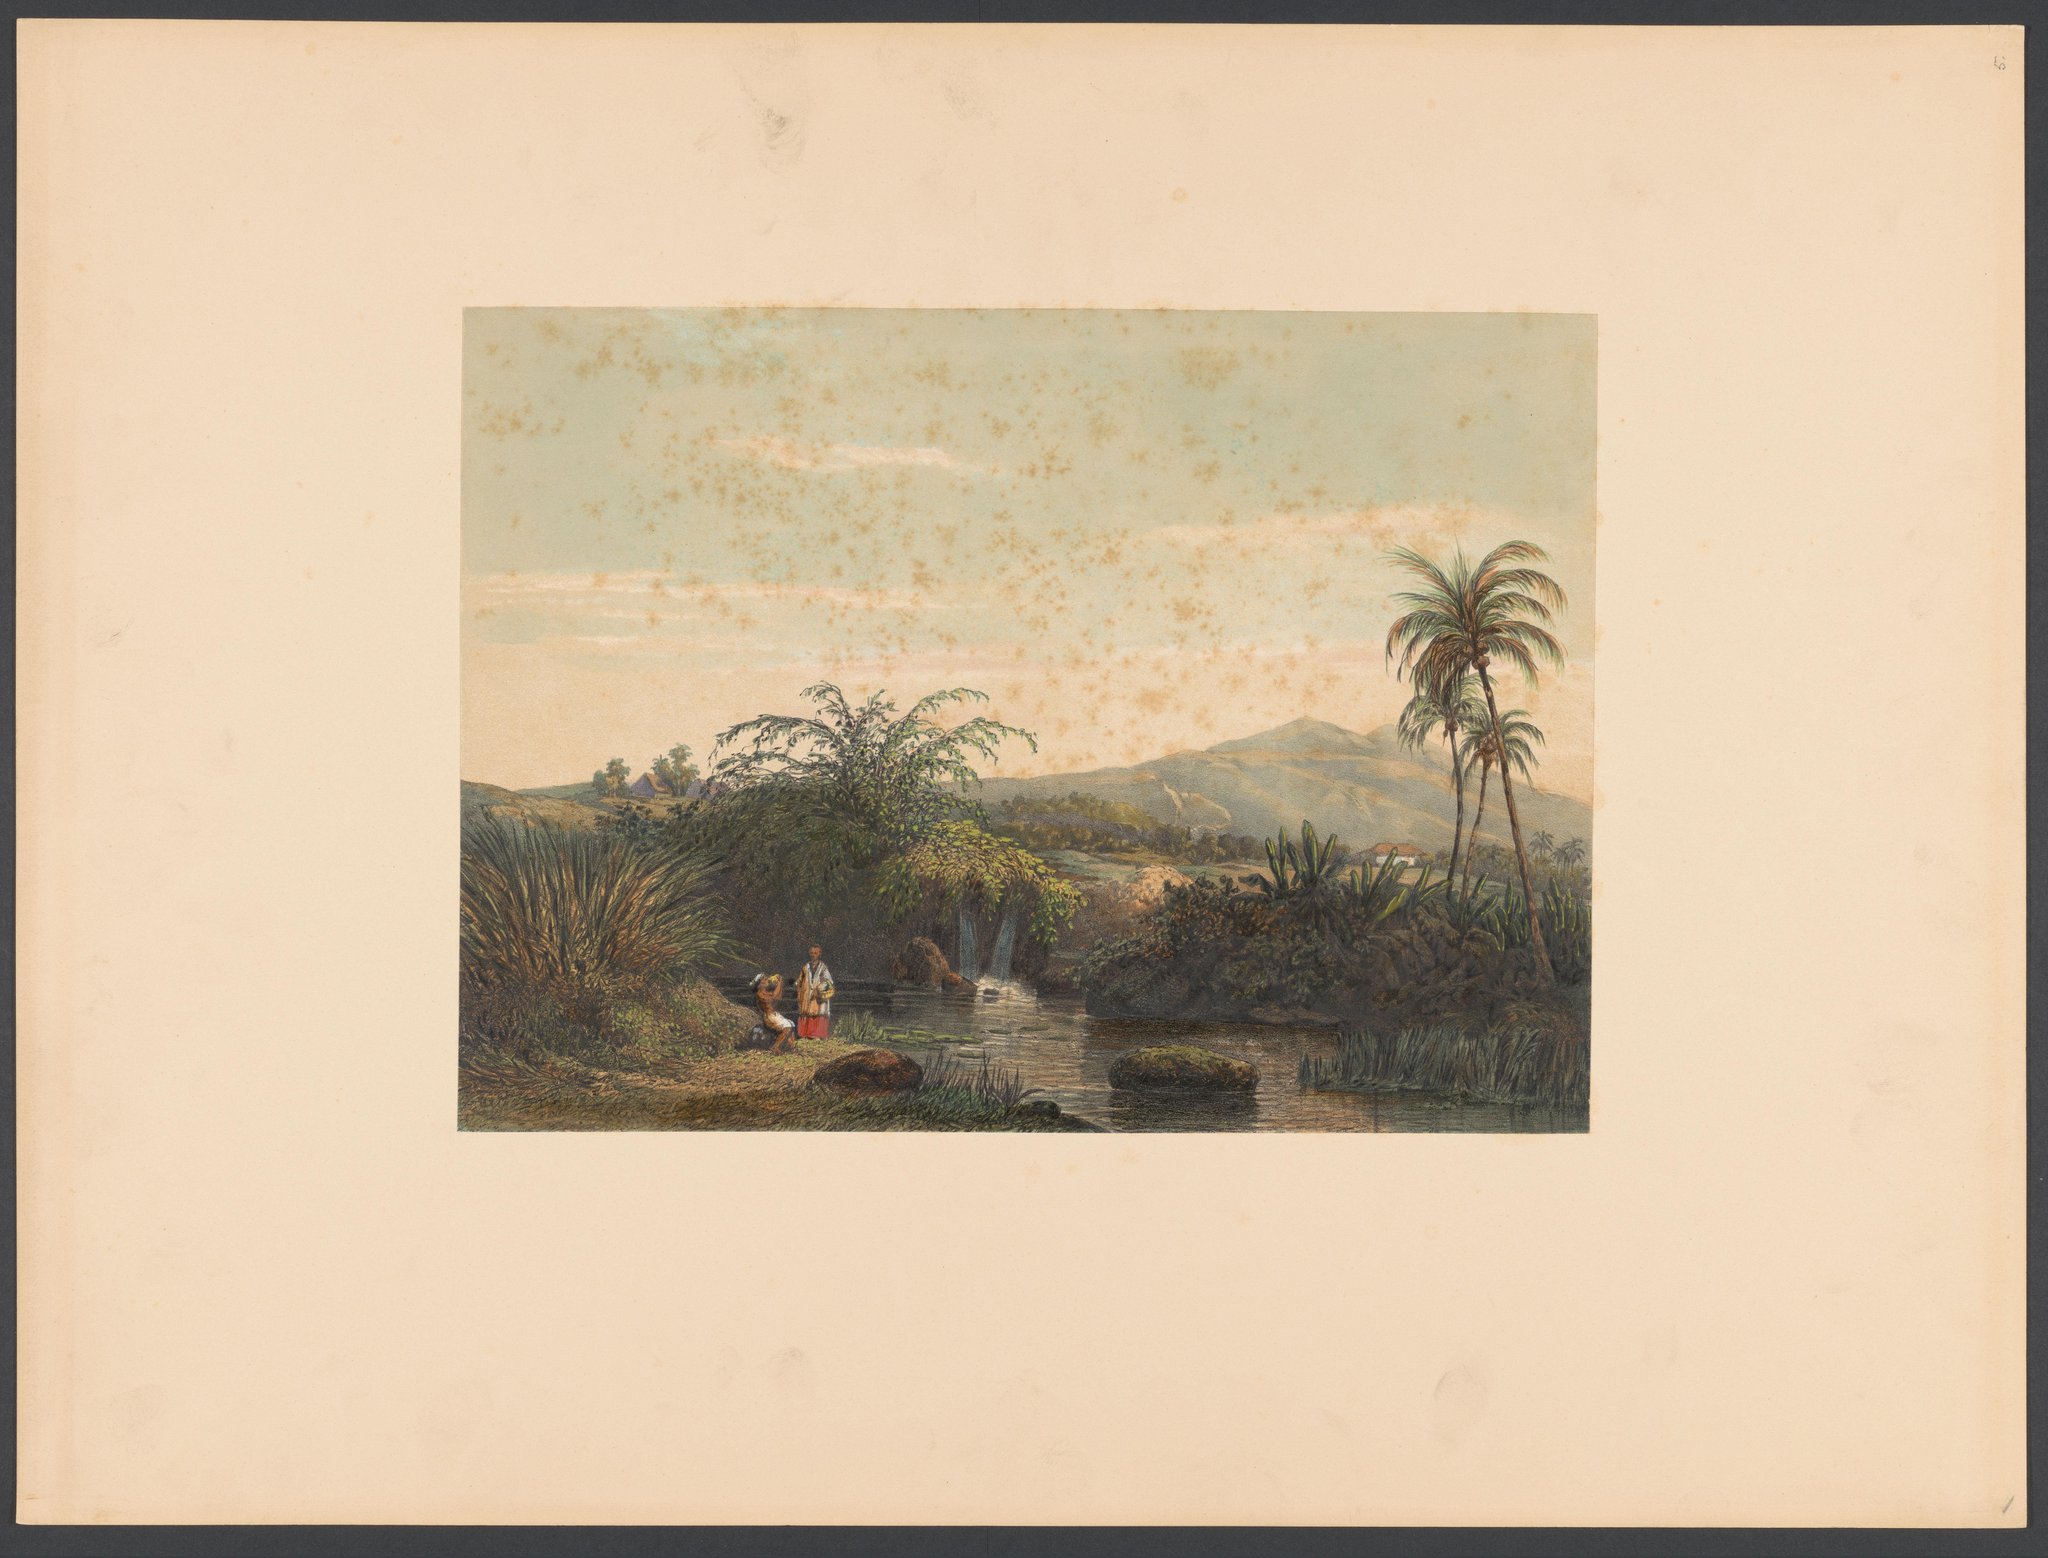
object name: print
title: Gezicht op het land Tjiliboet; Assistent-Residentie Buitenzorg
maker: johan conrad greive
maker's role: draughtsman, painter, print maker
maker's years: 1837-1891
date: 1865-1872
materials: paper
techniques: lithograph, hand coloring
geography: java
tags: waterfall, landscapes (+ landscape with figures, staffage), river (+ landscape with figures, staffage), java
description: In een landschap bij een rivier met een kleine waterval staan twee figuren. Een van hen drinkt uit een kruik. De prent maakt deel uit van een map met 24 bladen.